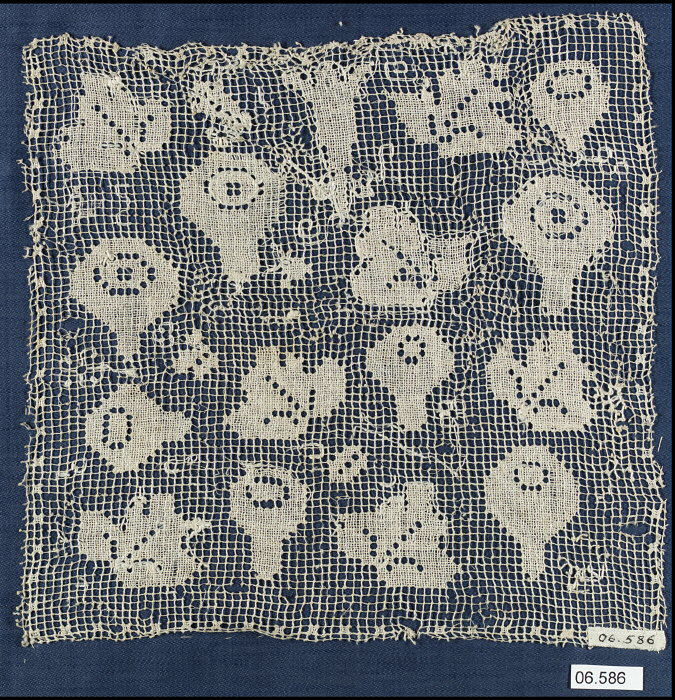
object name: square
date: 1501-1700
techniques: embroidery